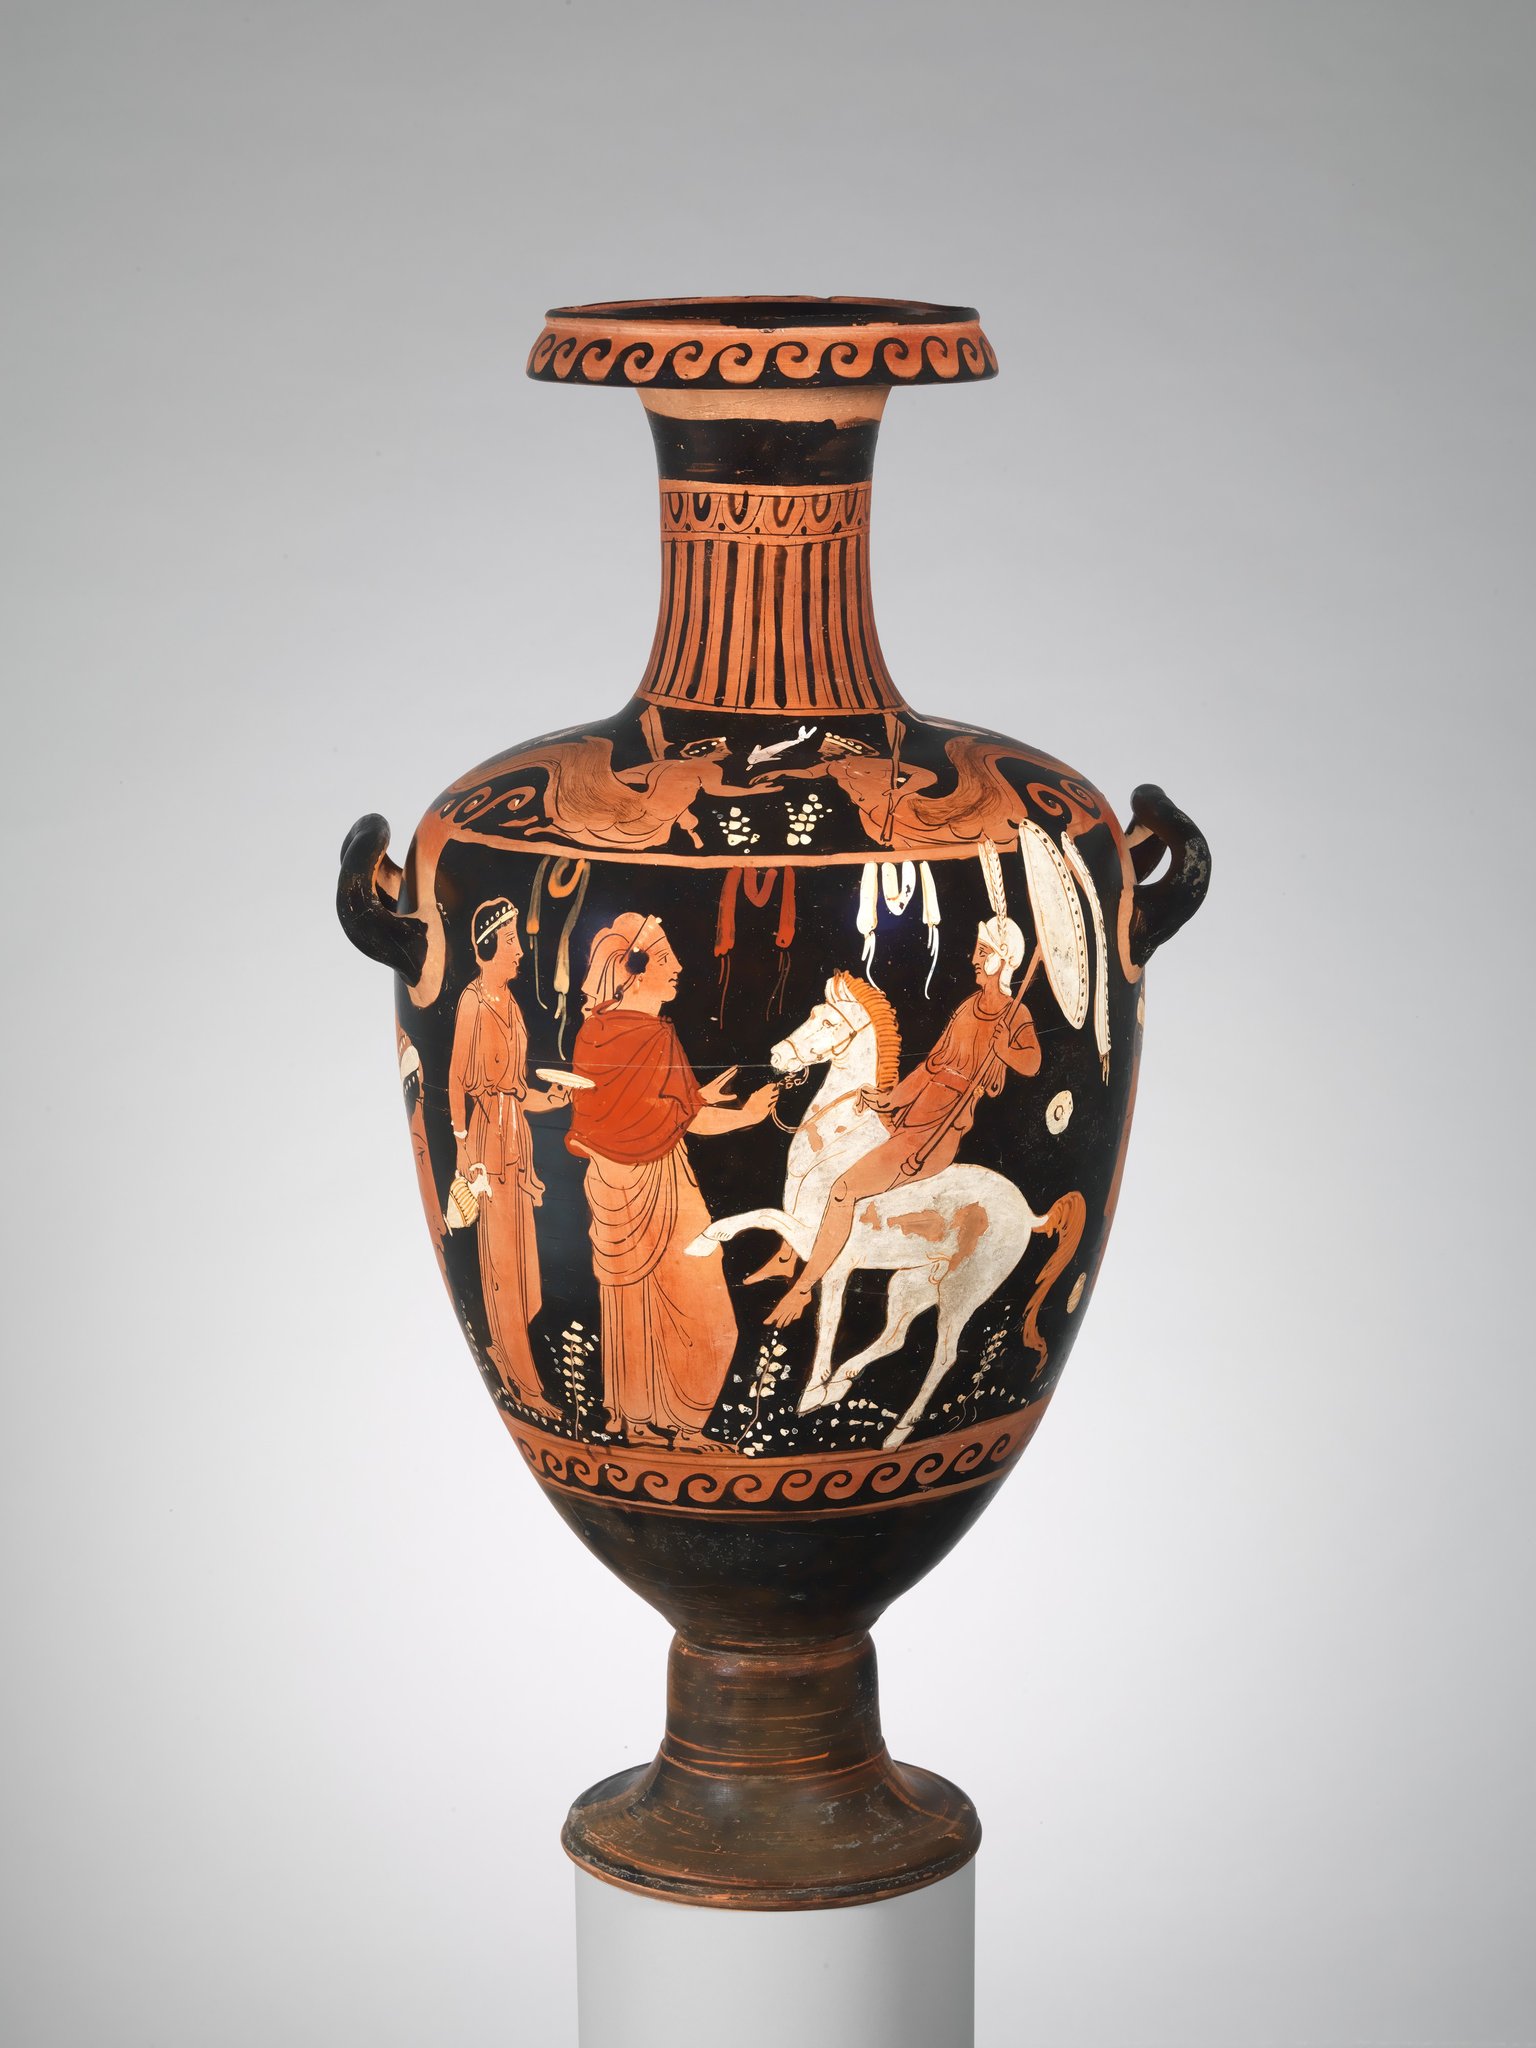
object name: hydria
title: Terracotta hydria (water jar)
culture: greek or south italian or campanian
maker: group of naples 3227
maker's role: artist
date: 350-320 BCE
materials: terracotta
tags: shields,men,women,horses,warriors